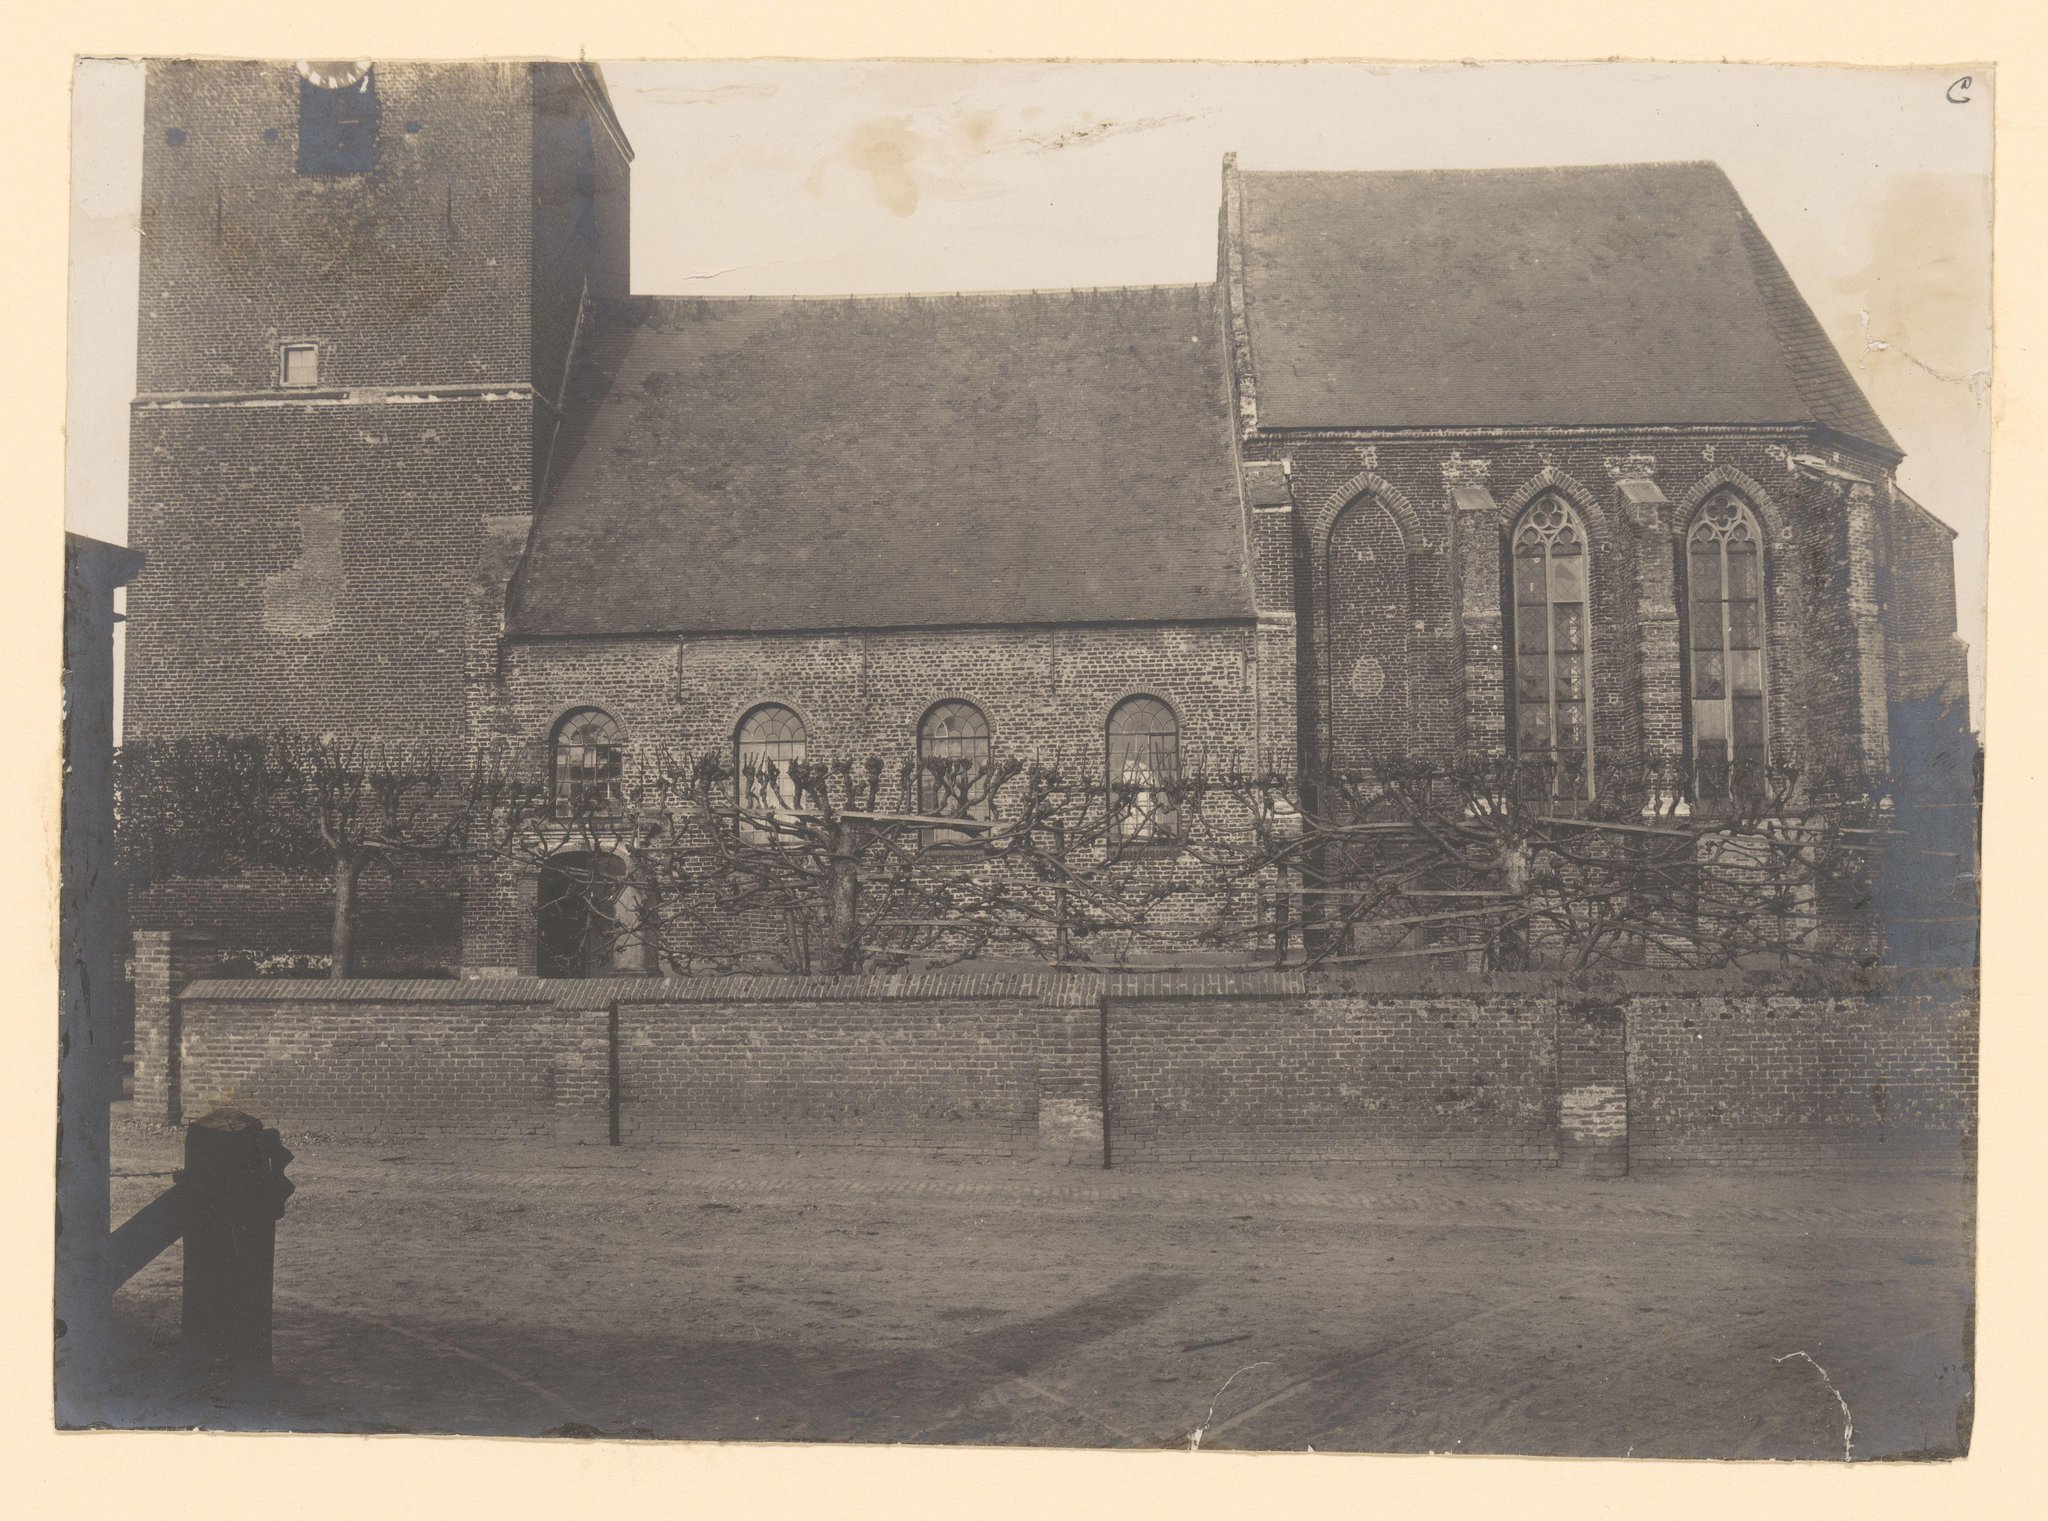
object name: photograph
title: Gezicht op de voormalige Rooms-Katholieke kerk te Horssen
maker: anoniem (monumentenzorg)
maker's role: fotograaf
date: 1908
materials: cardboard, photographic support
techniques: gelatin silver print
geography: horssen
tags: church (exterior)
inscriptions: annotation: ‘c’, annotation: ‘Horssen (G.)/ Oct 1908’